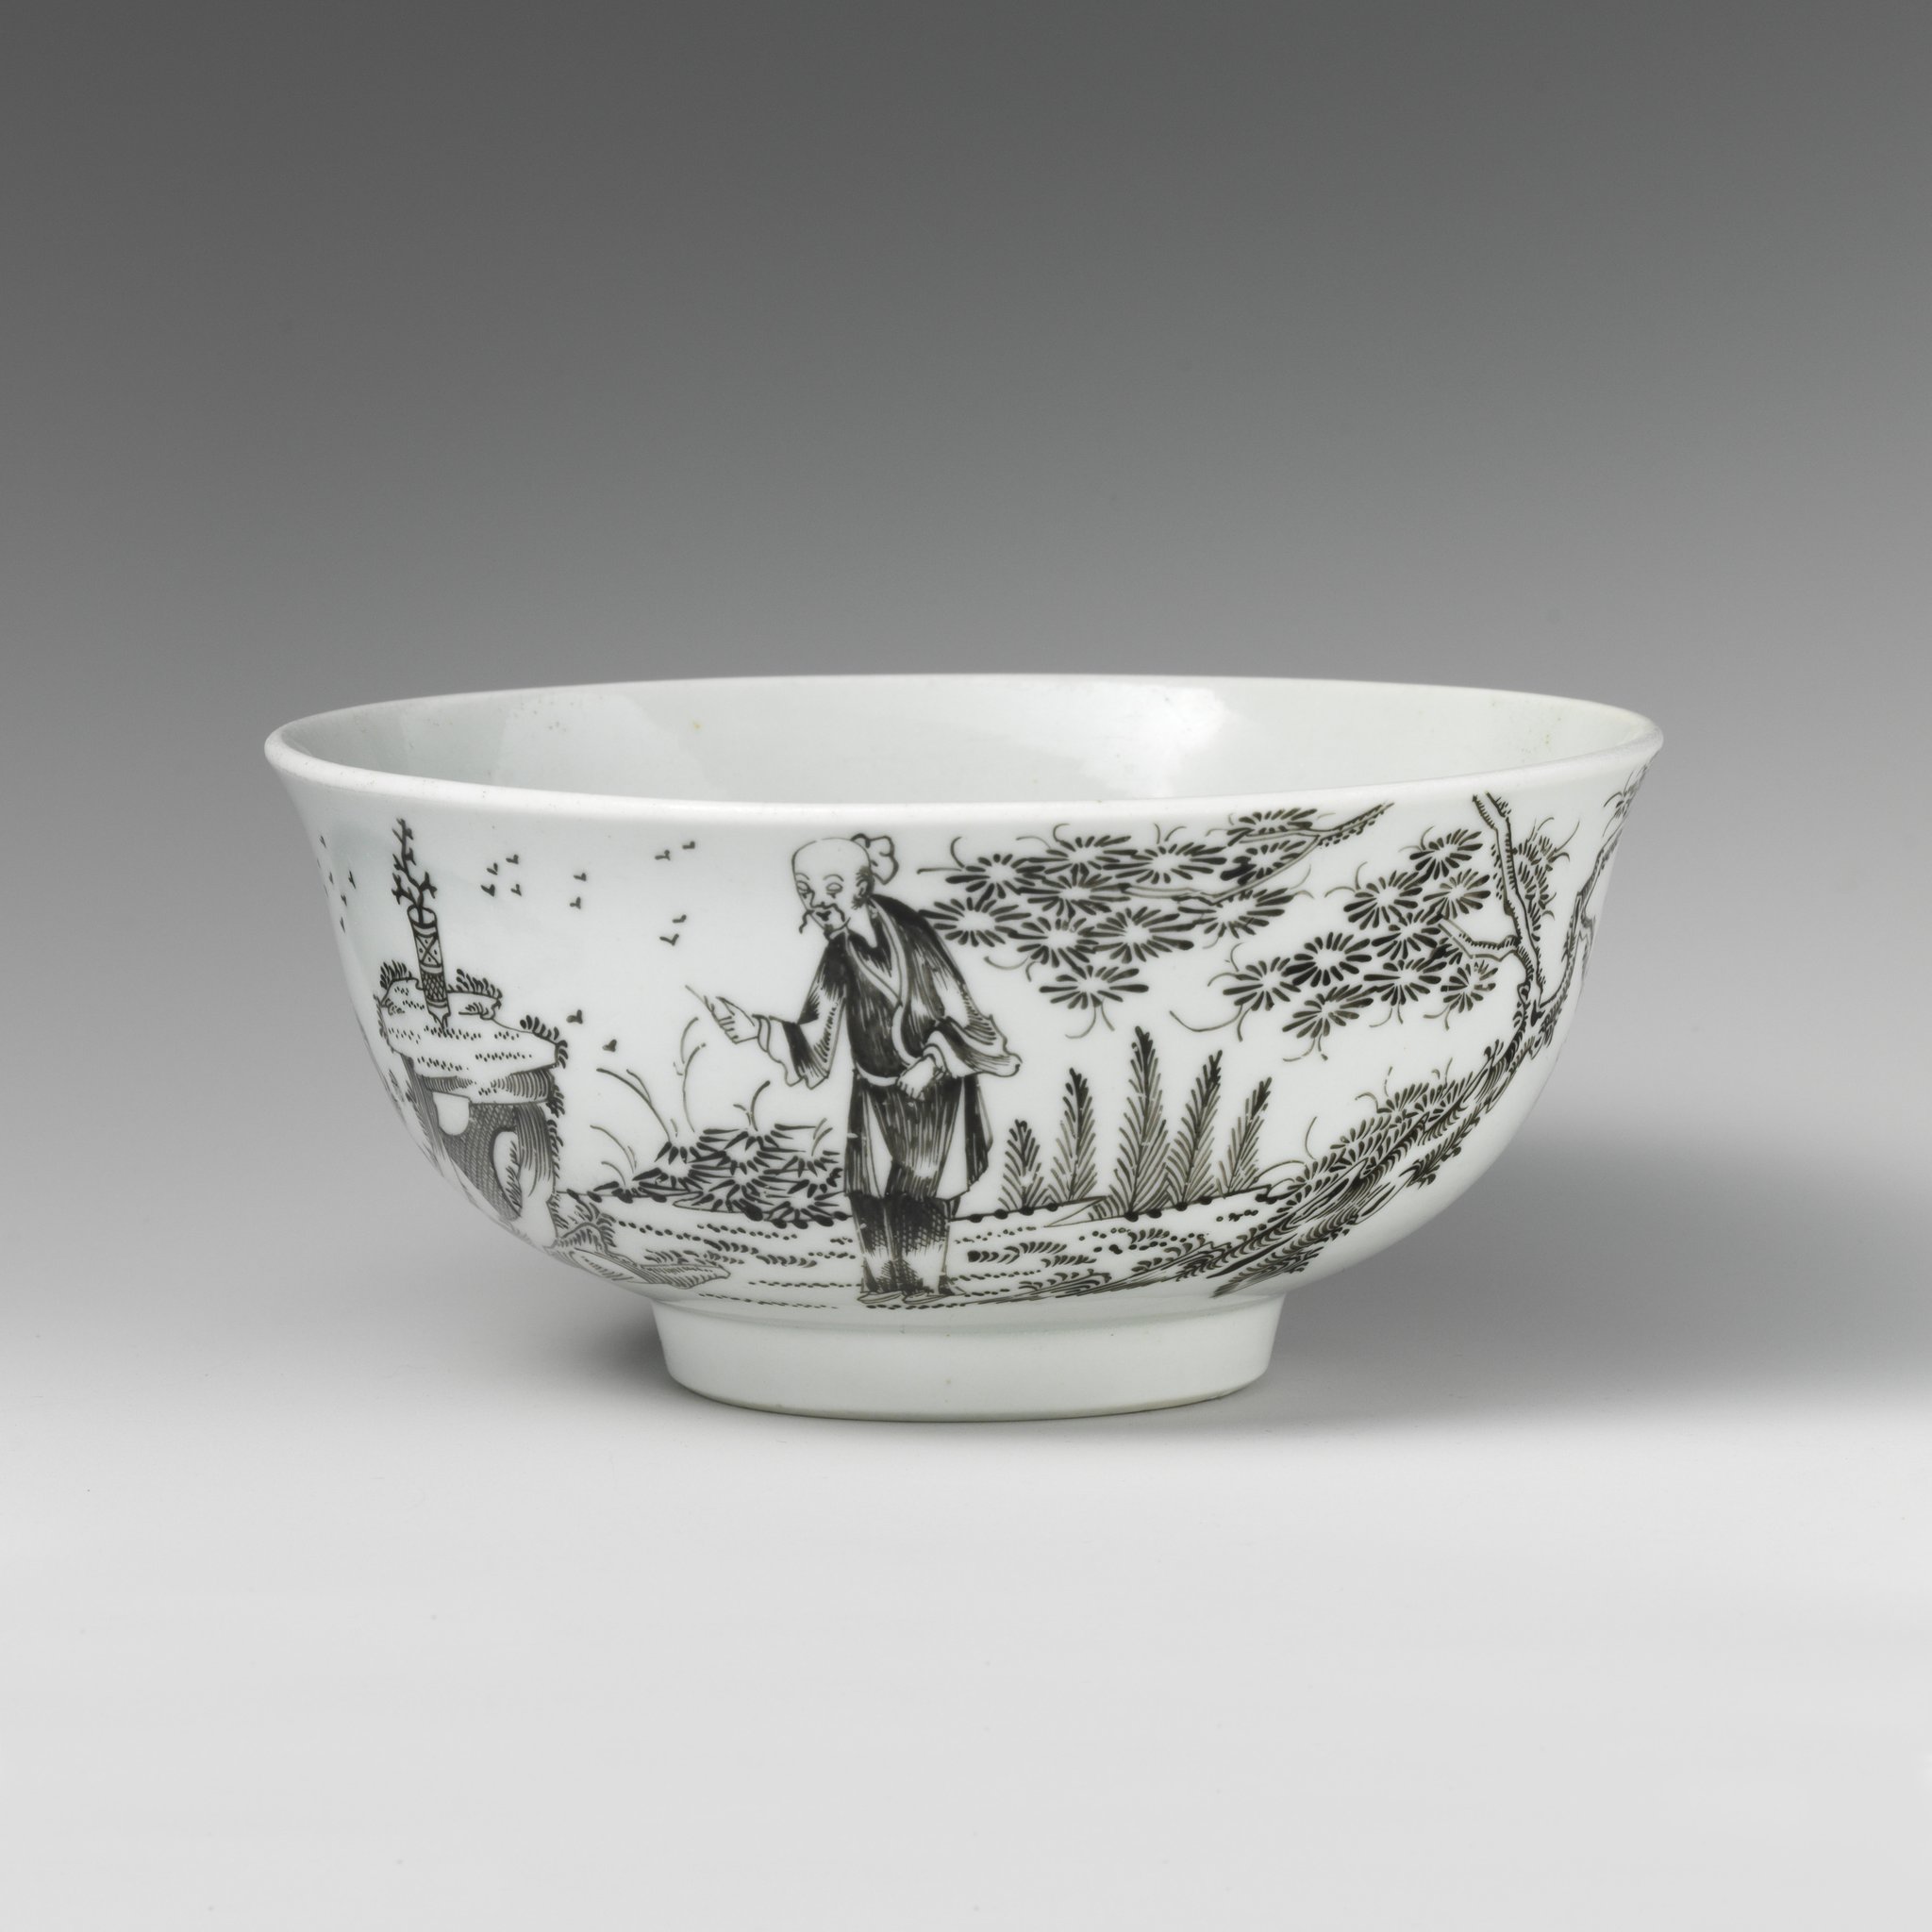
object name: bowl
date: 1701-1800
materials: soft paste porcelain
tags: men,flowers,trees